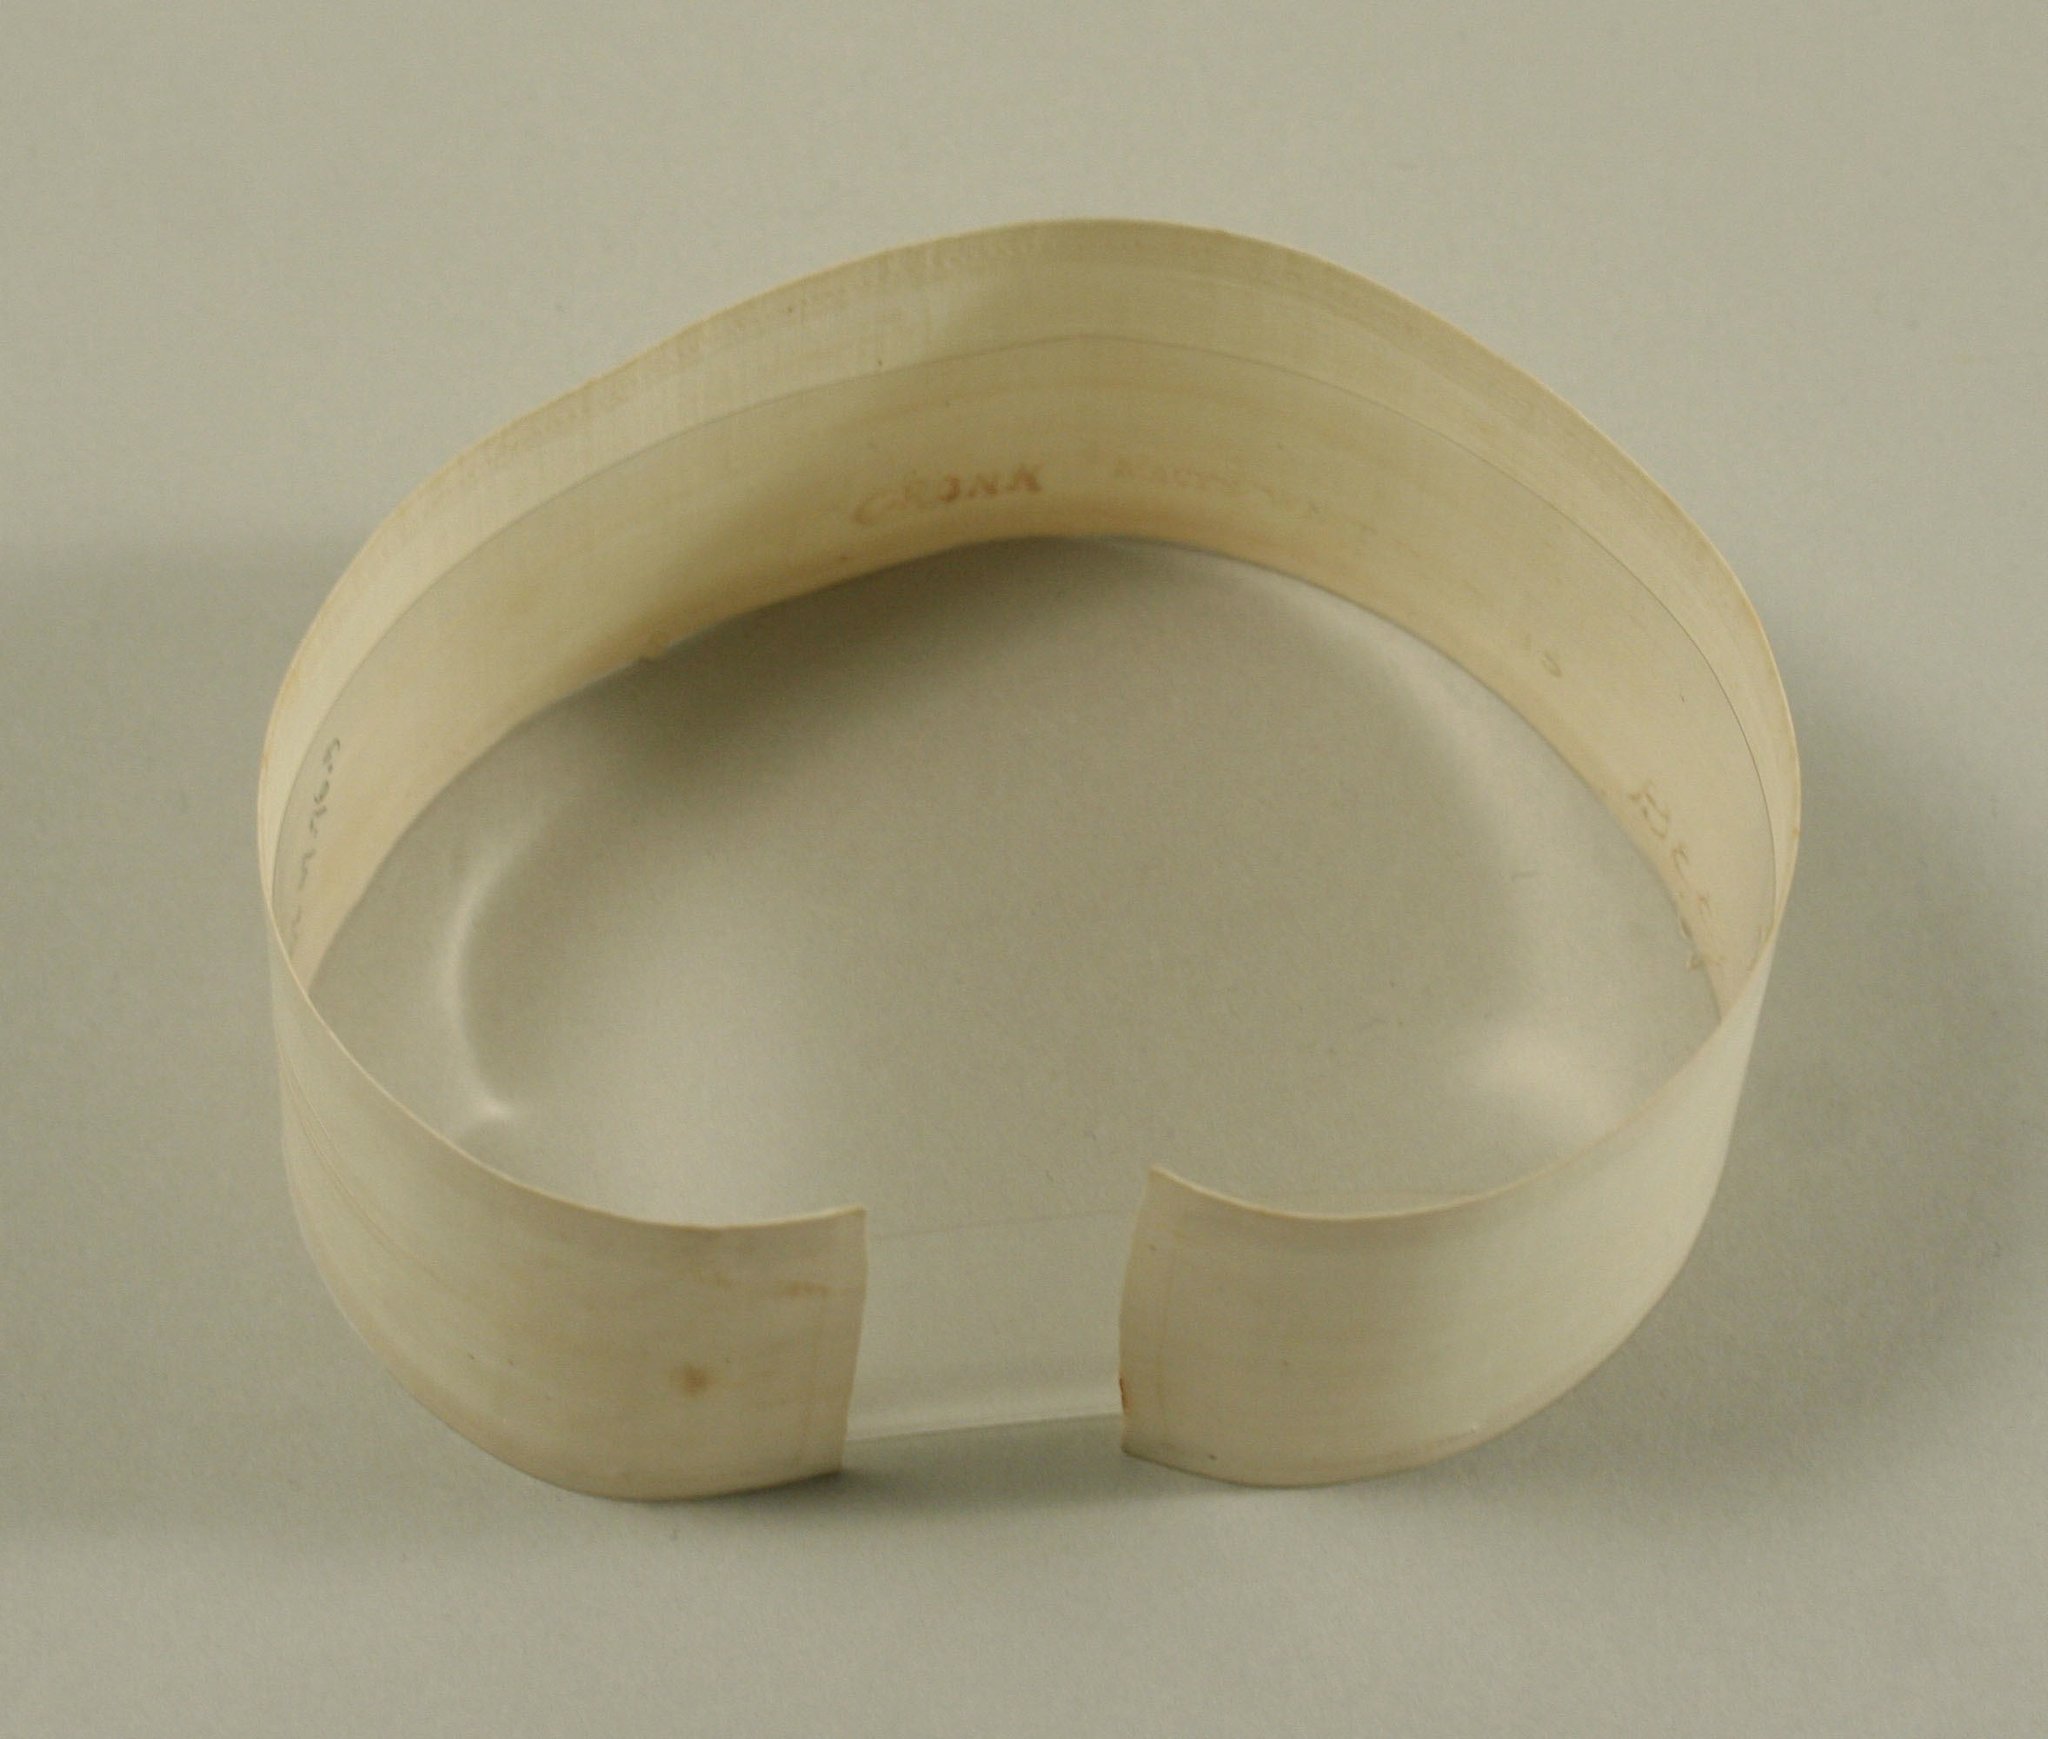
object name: collar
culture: american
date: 1880-1884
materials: linen